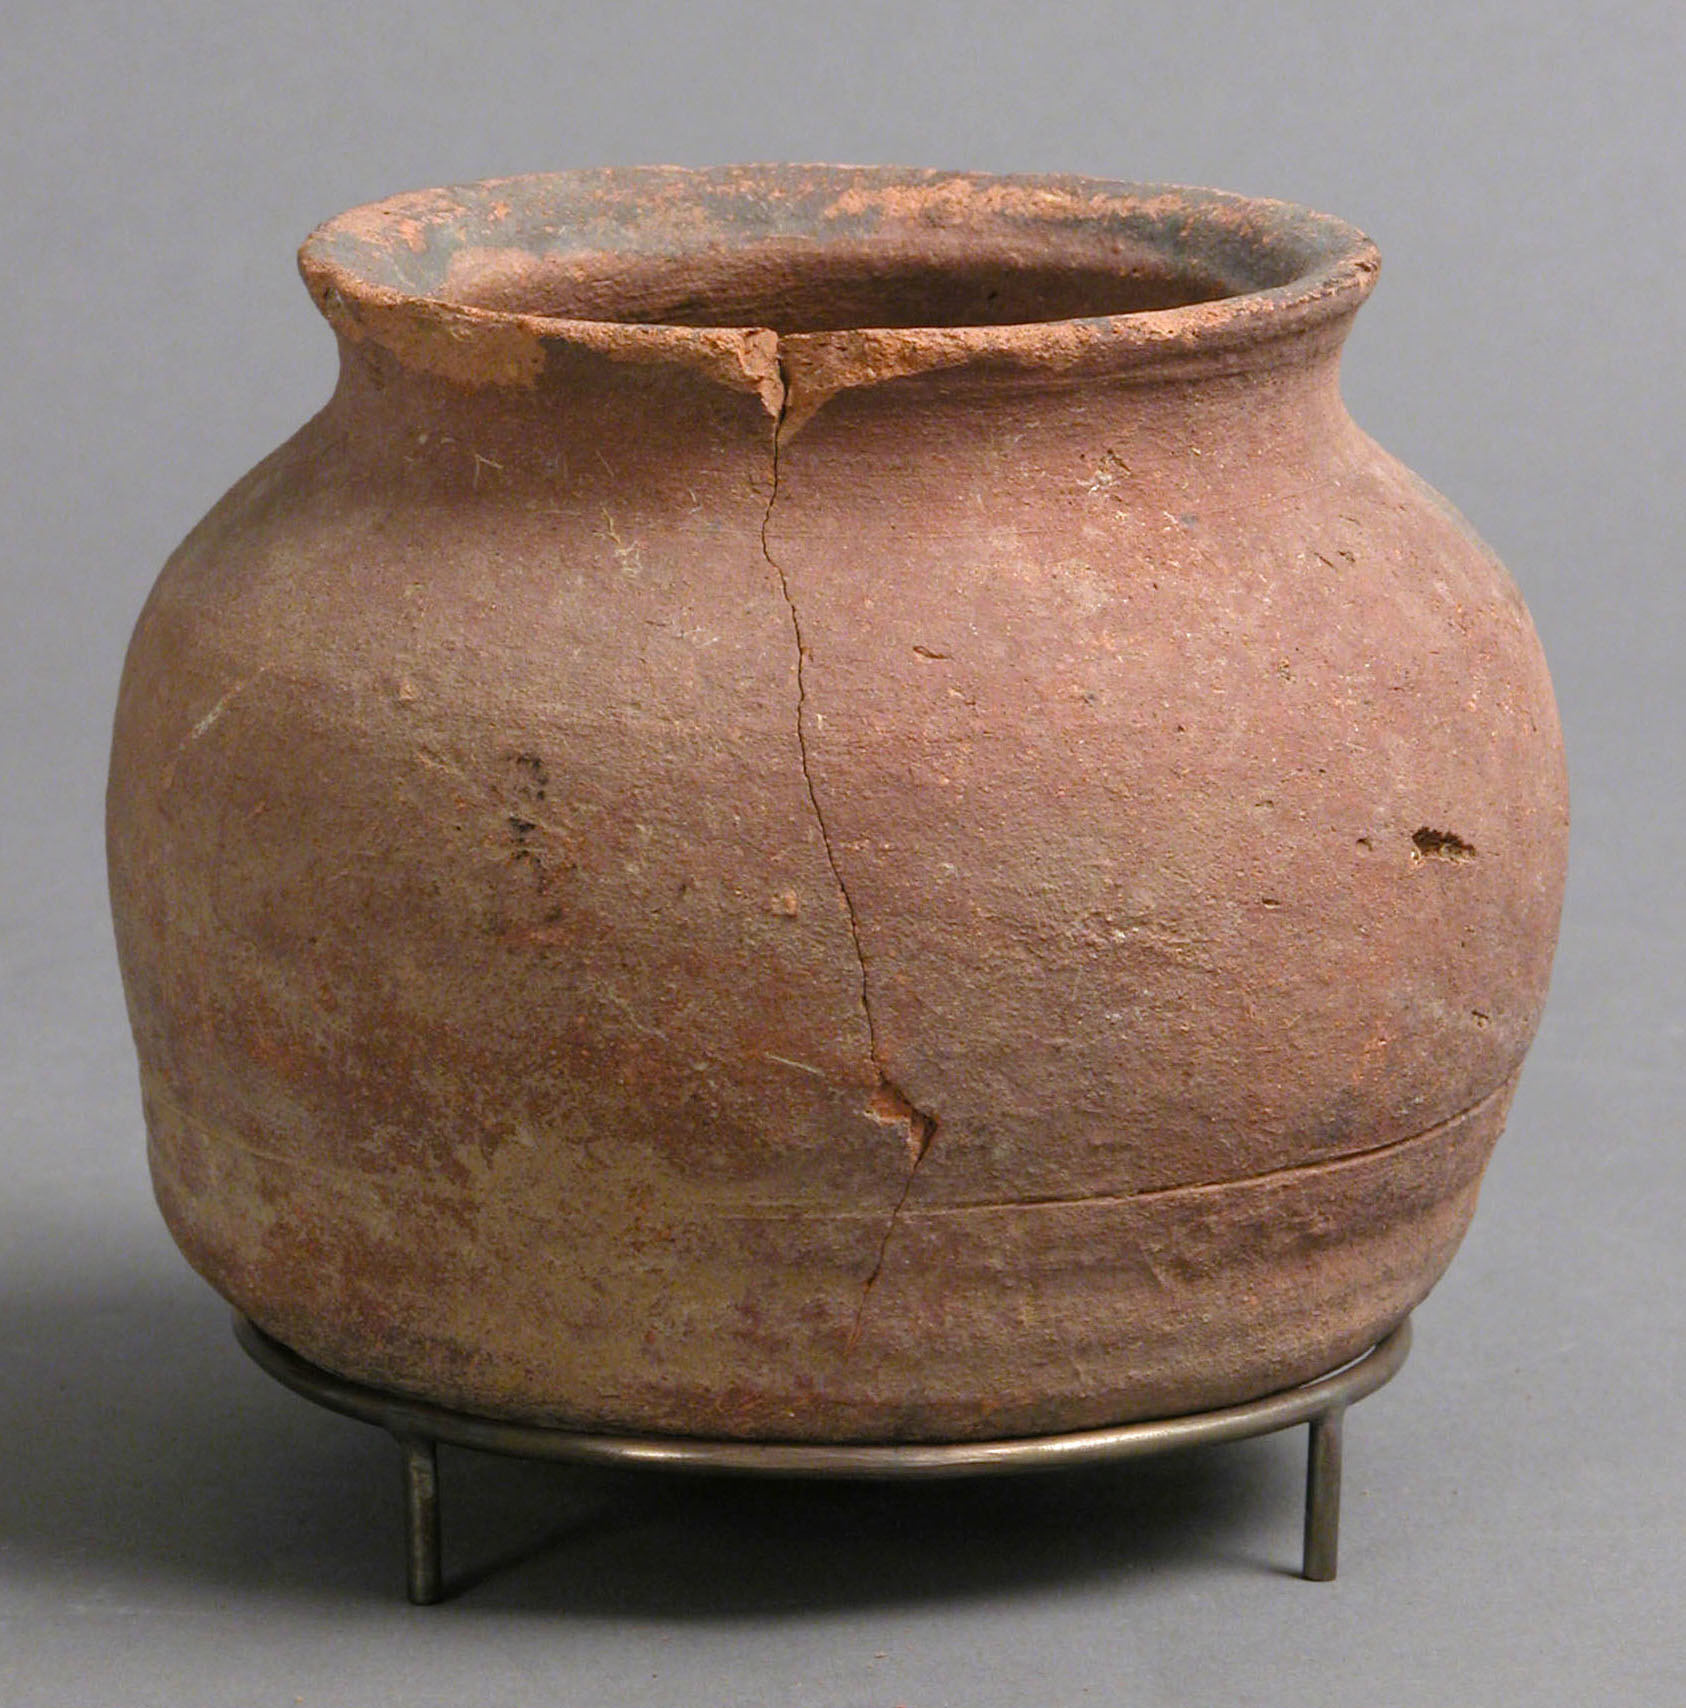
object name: pot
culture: coptic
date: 301-700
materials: earthenware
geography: egypt